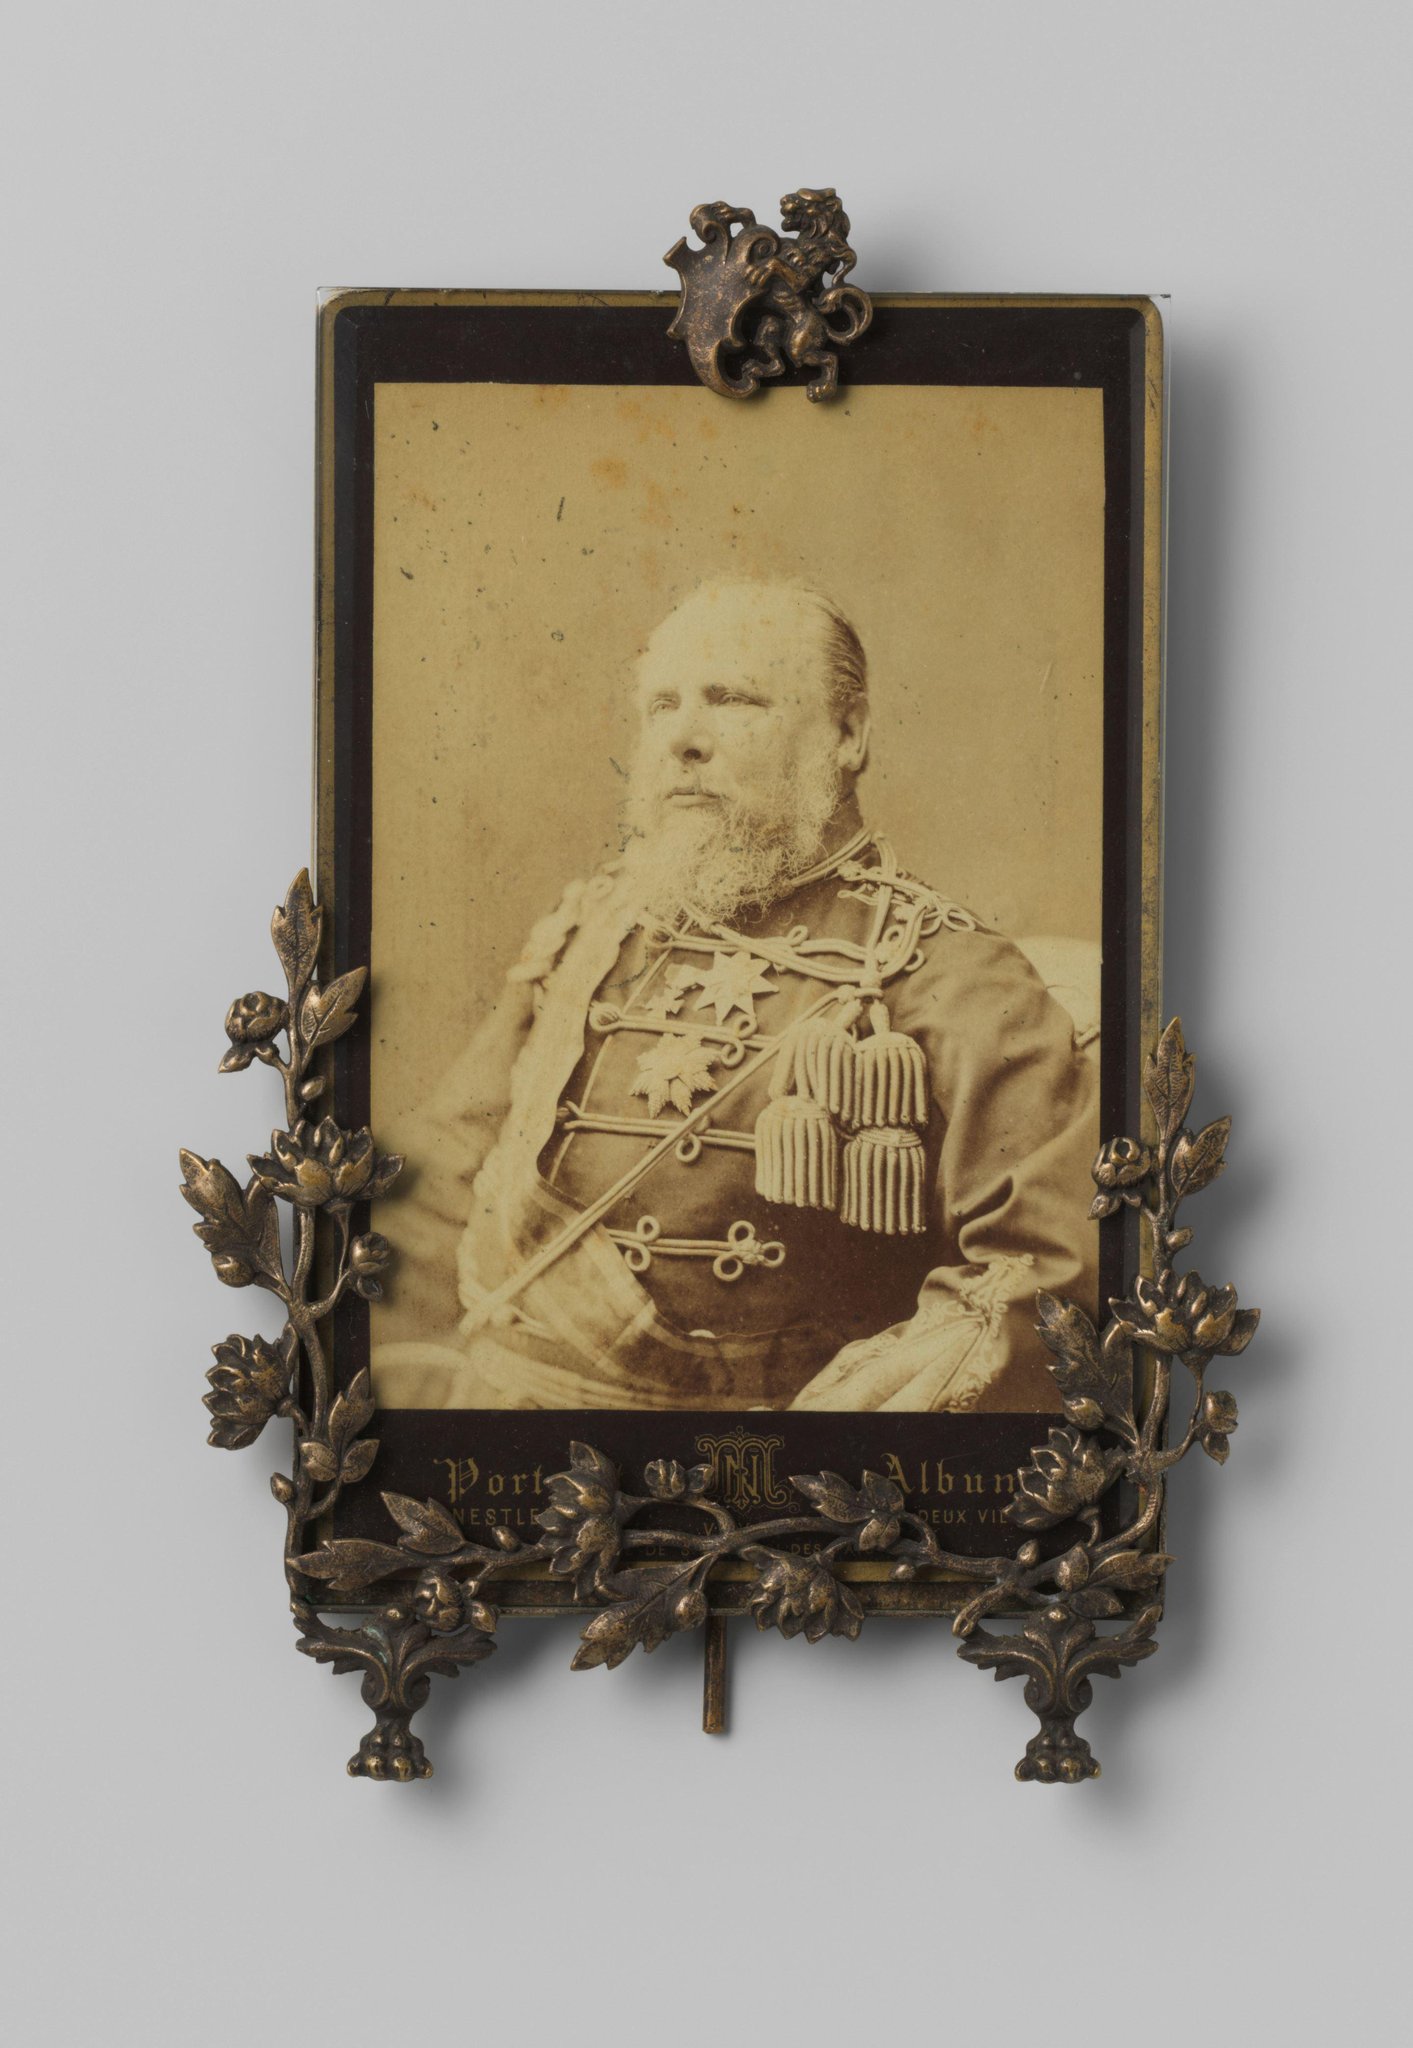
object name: frame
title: Portret van koning Willem III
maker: martin nestler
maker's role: fotograaf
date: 1875-1890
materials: cardboard, glass, metal, paper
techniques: albumen print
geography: vevey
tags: brussels, willem iii (koning der nederlanden), historical persons, (military) uniforms, king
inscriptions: inscription: ‘M. Nestler/ Photographe breveté de/ S.M. le Roi/ des Pays-Bas/ Entre Deux Villes/ Vevey./ Les Clichés sont conservés.’